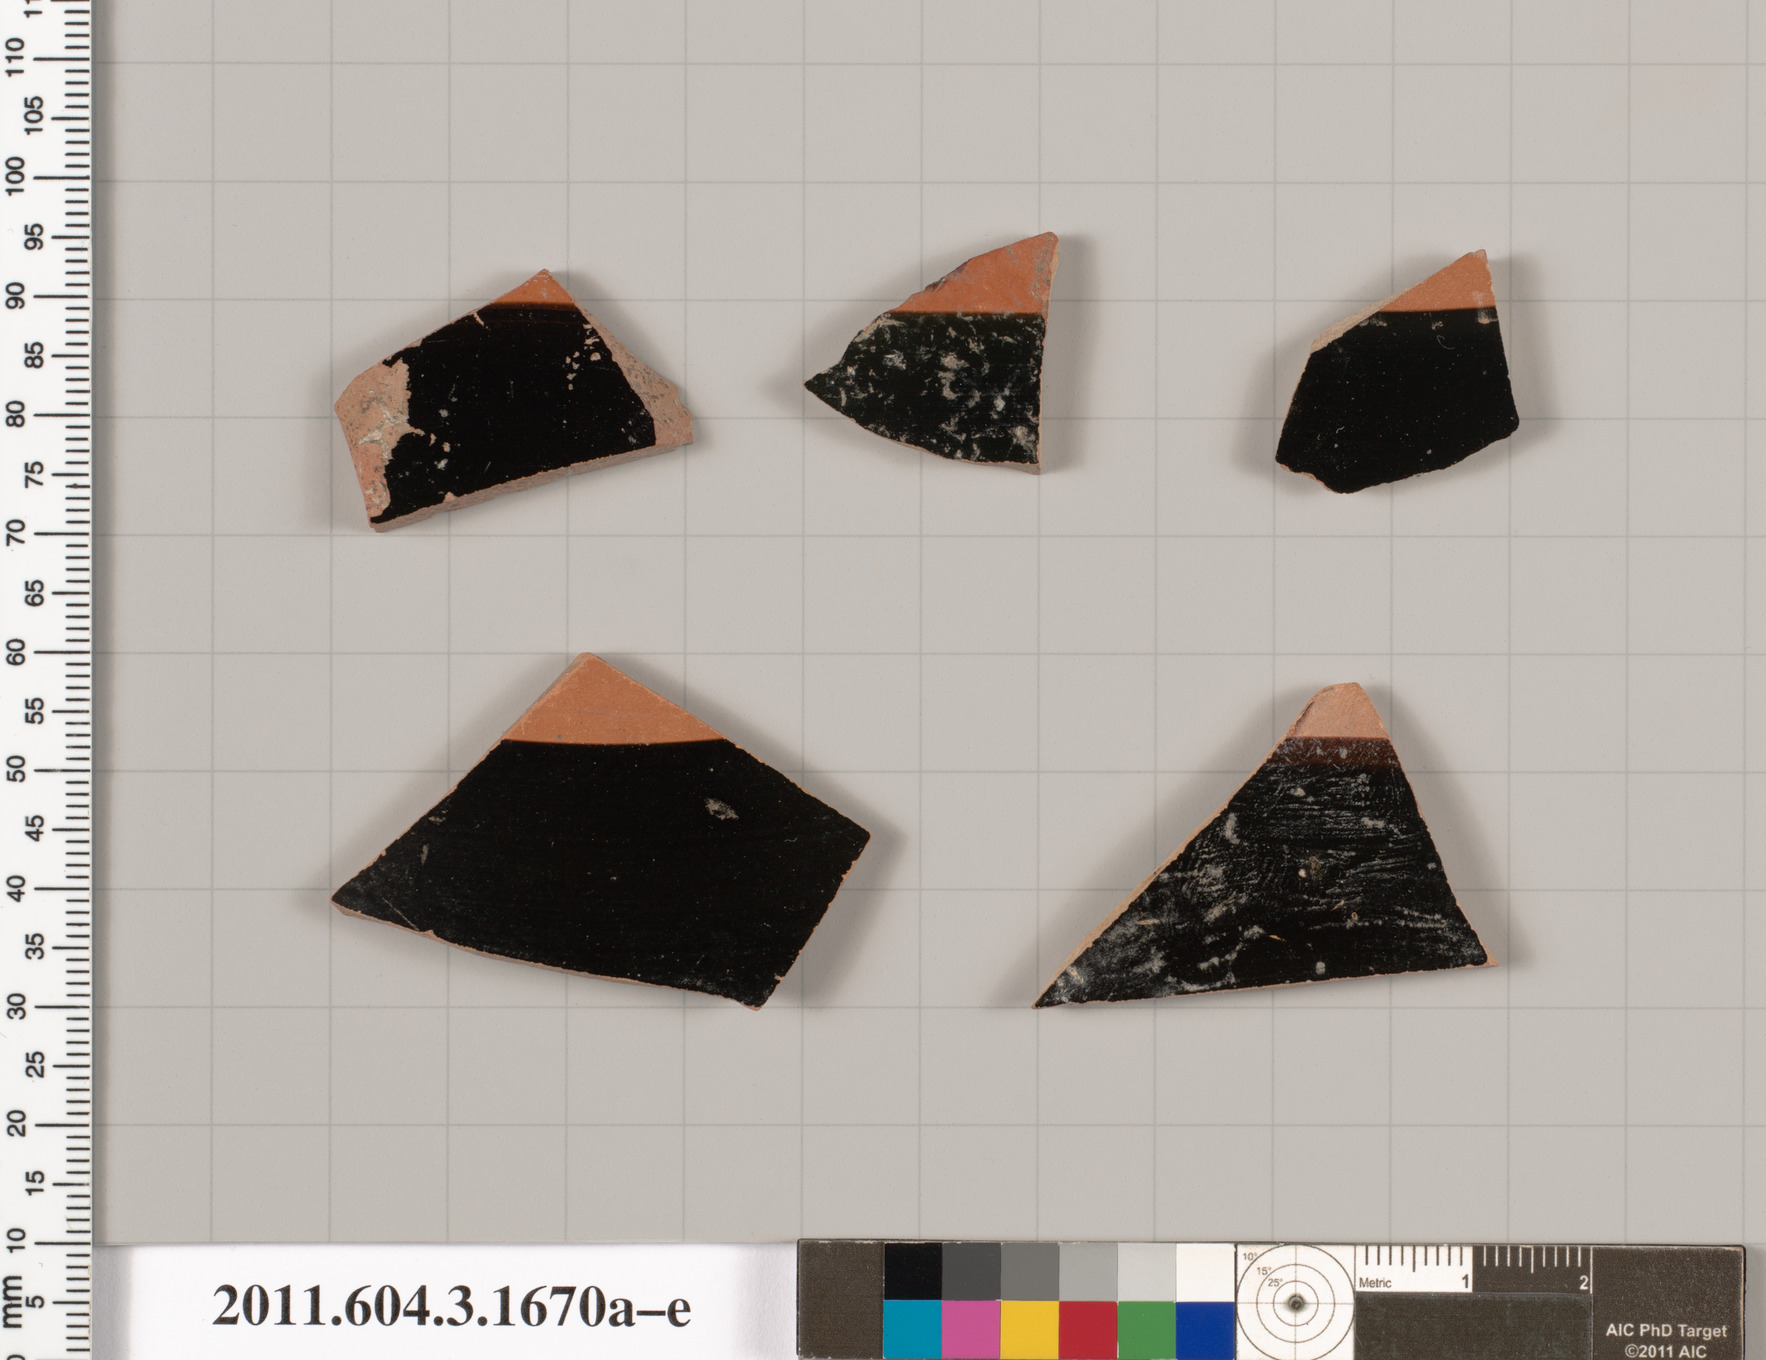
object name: kylix fragment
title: Terracotta fragments of kylikes: Band or lip cups (drinking cups)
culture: greek, attic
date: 550-526 BCE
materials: terracotta